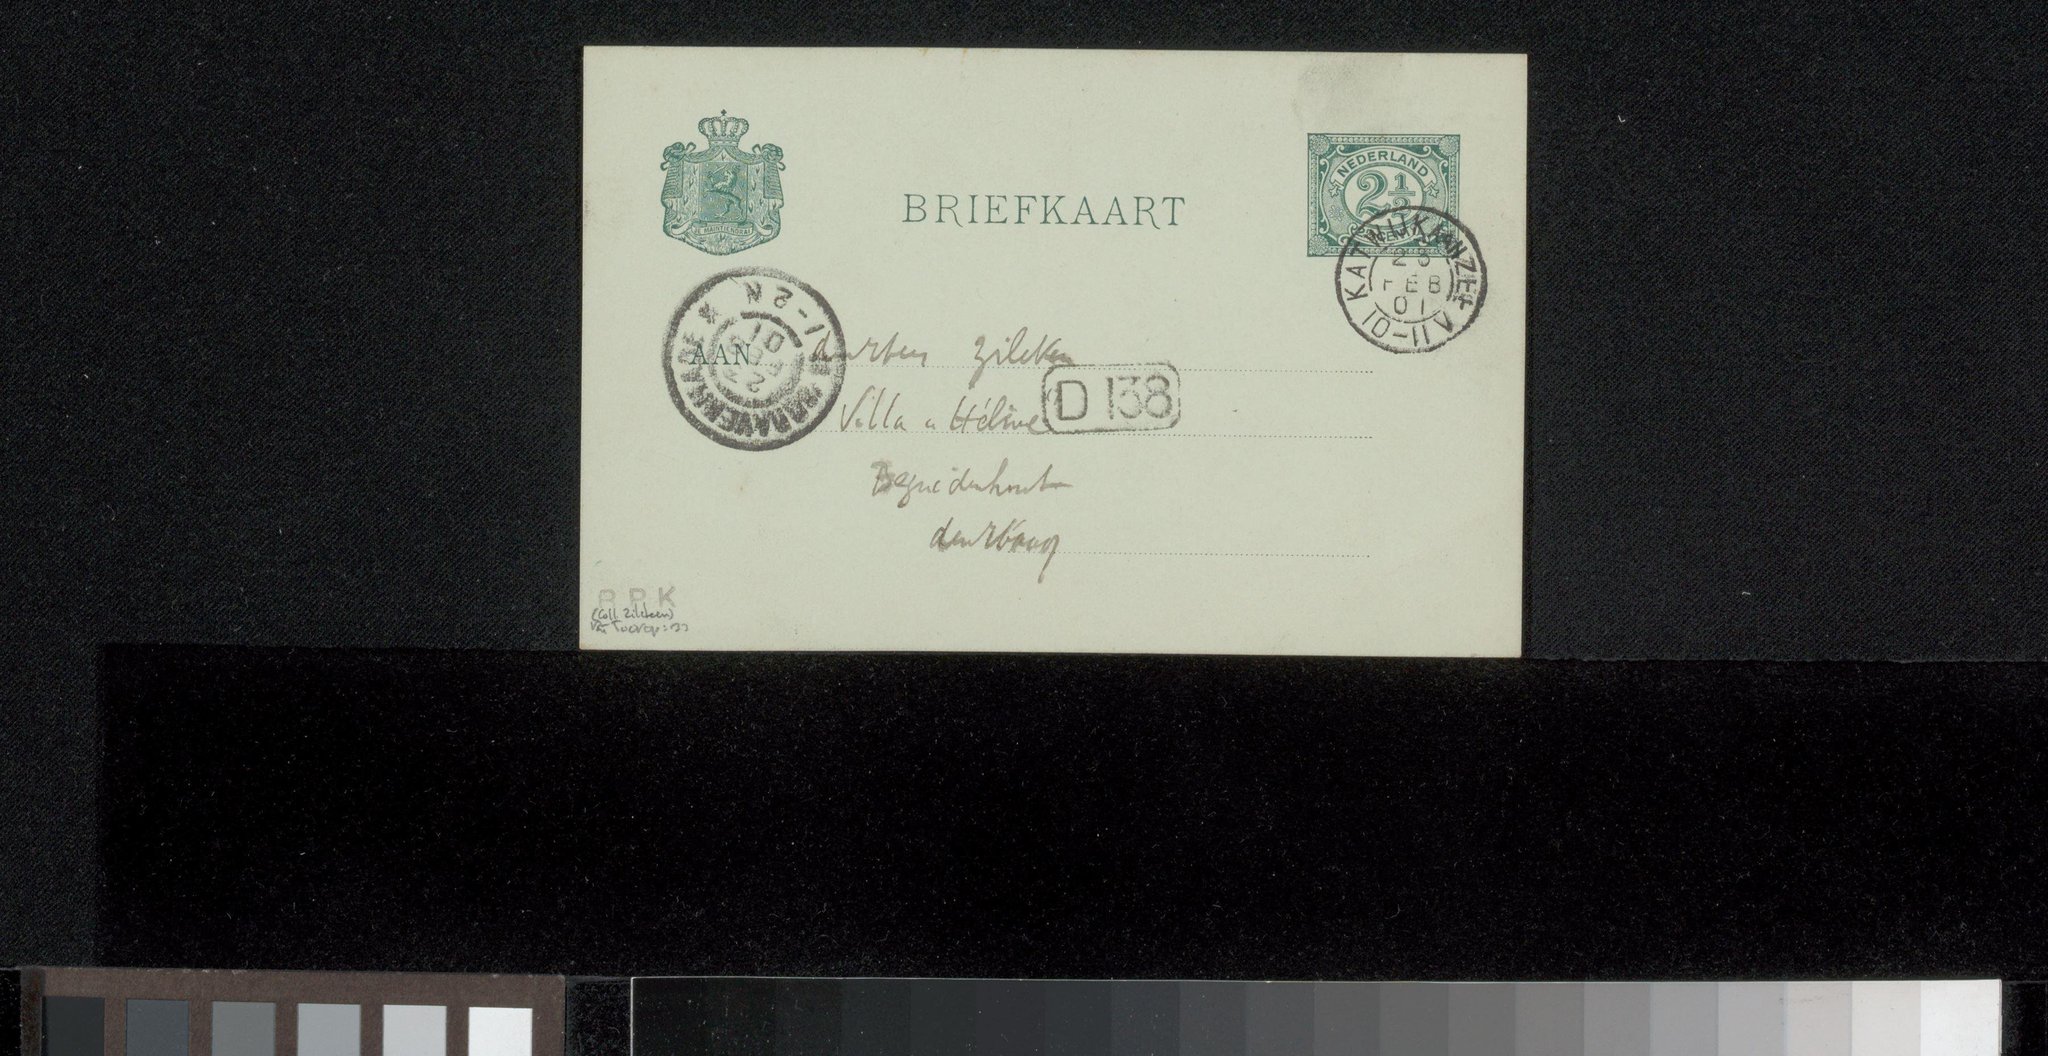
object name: postcard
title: Briefkaart aan Philip Zilcken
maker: jan toorop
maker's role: draughtsman, painter, print maker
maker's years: 1858-1928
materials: cardboard, ink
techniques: pen, writing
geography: katwijk aan zee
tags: the hague, painter, draughtsman, philip zilcken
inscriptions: collector's mark: ‘RPK’